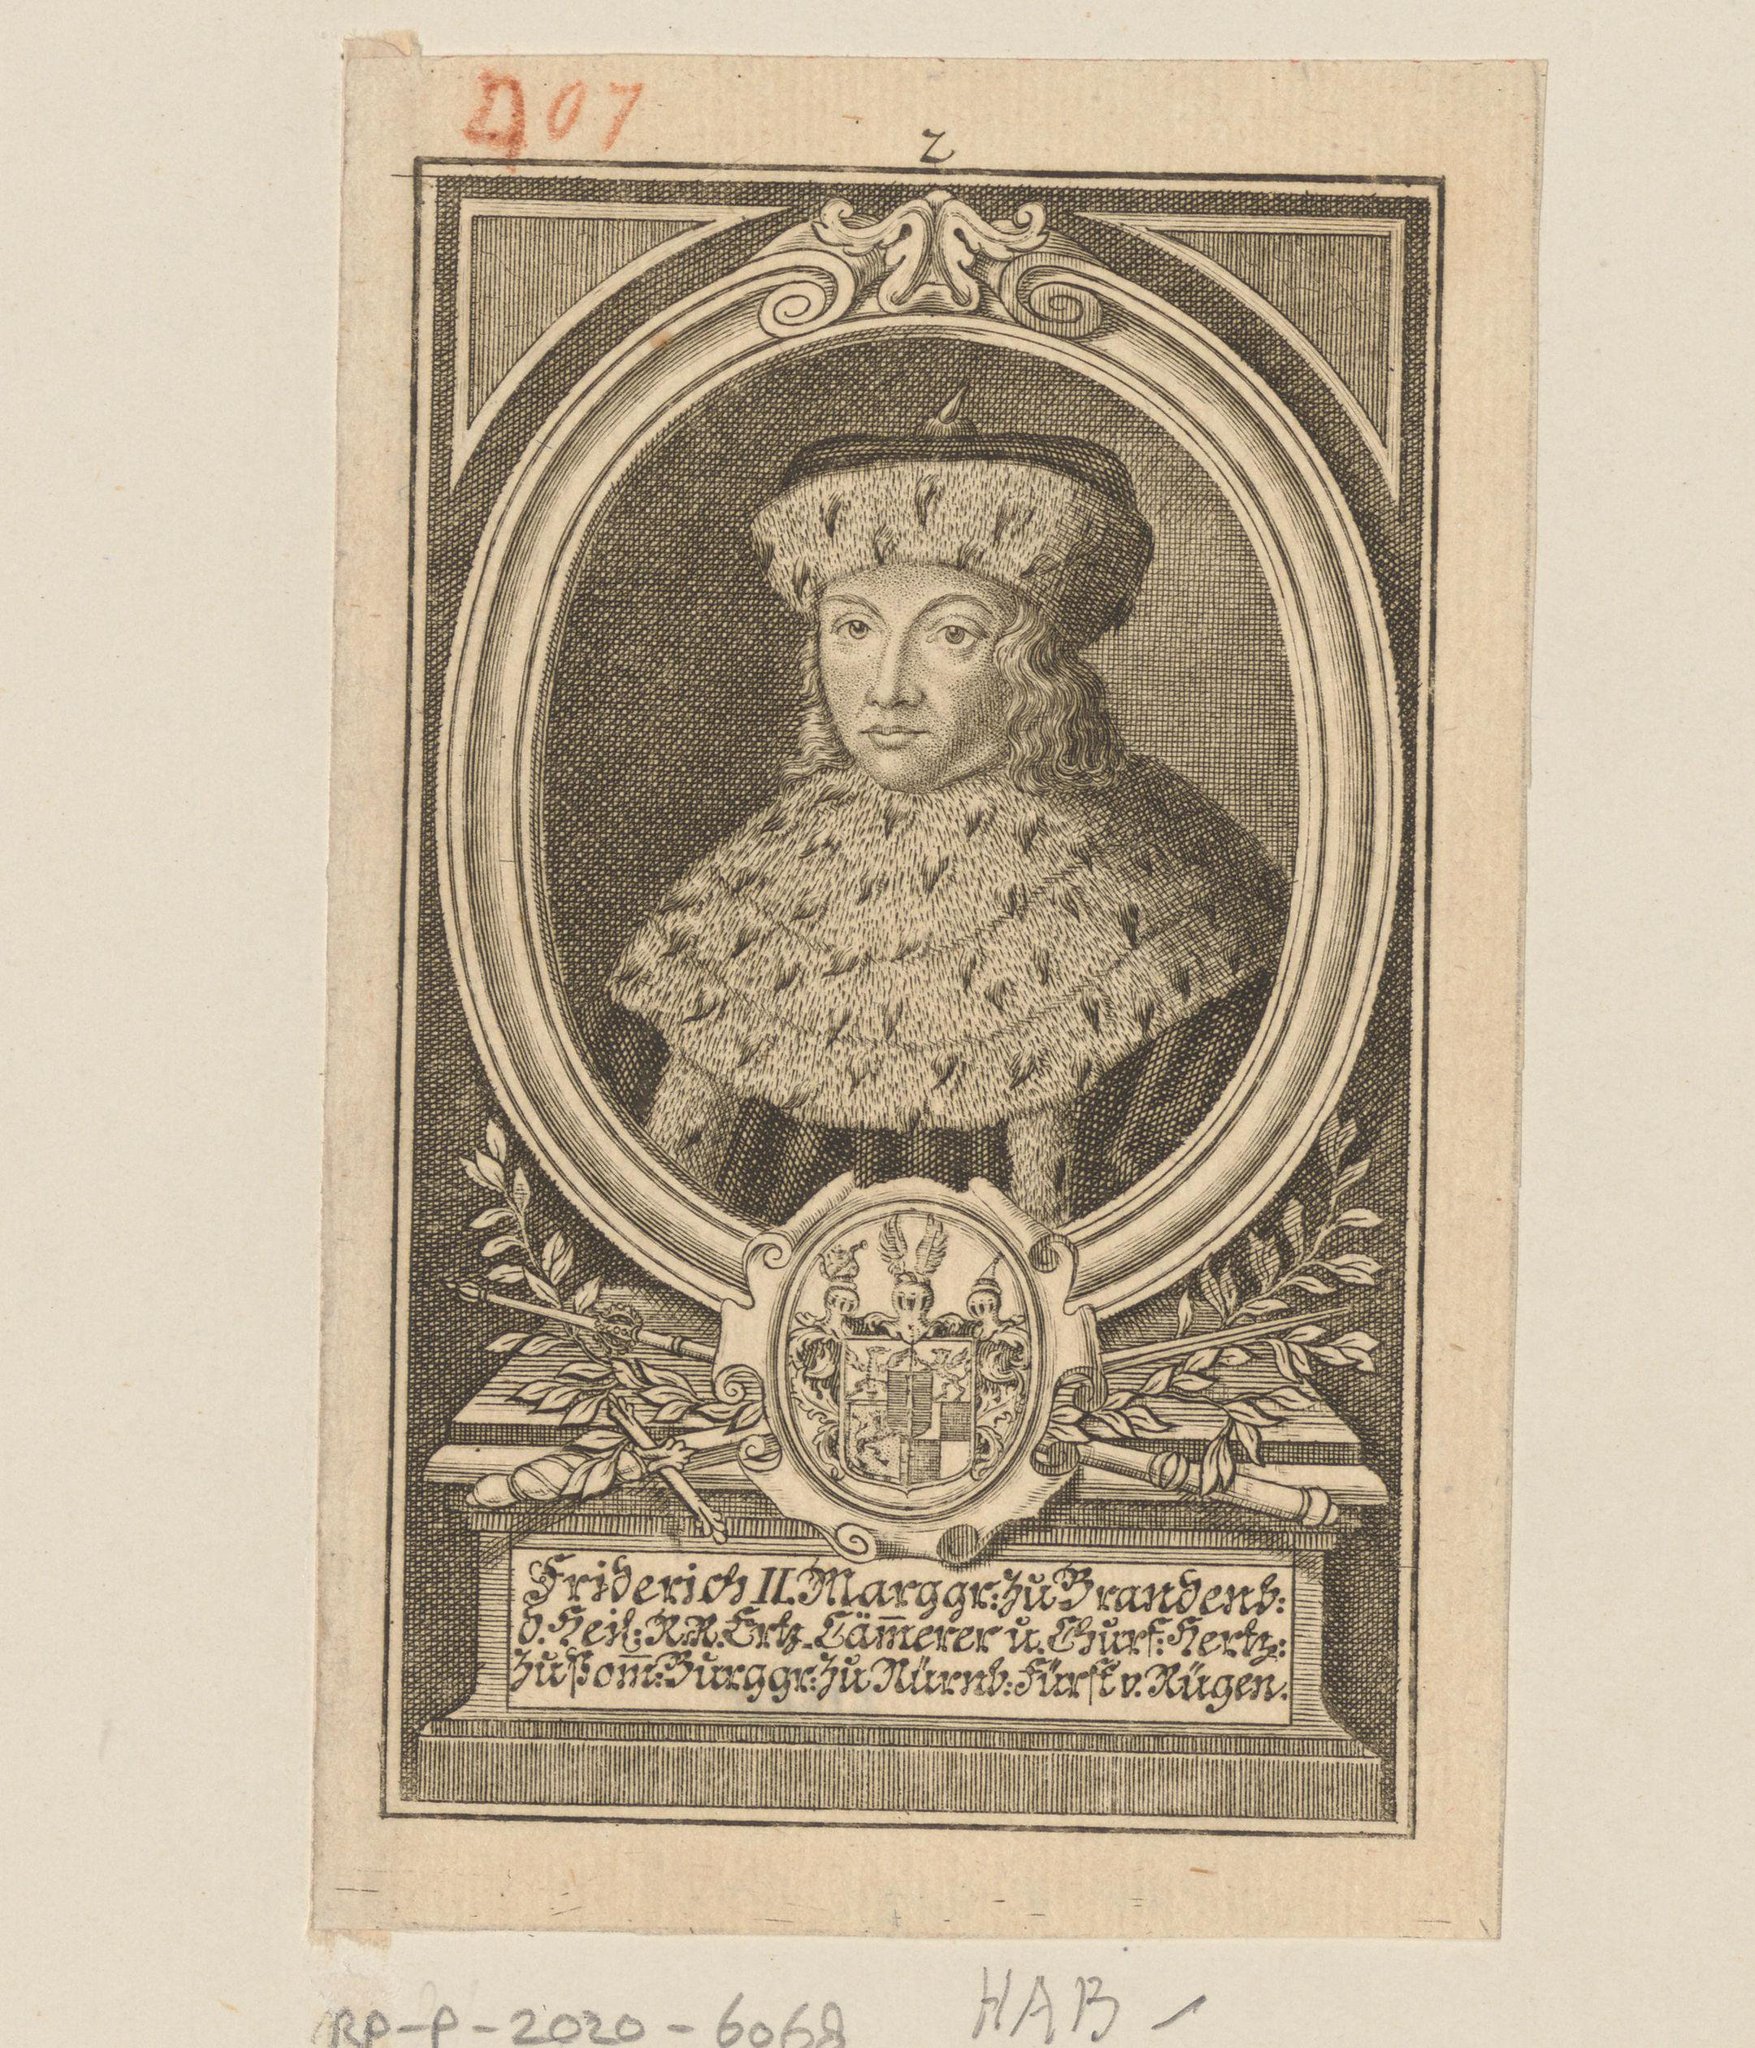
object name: print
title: Portret van Frederik II van Brandenburg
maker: Anonymous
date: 1650-1750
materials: paper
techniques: engraving, etching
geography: germany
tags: historical persons, armorial bearing, heraldry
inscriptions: collector's mark: Lugt 357